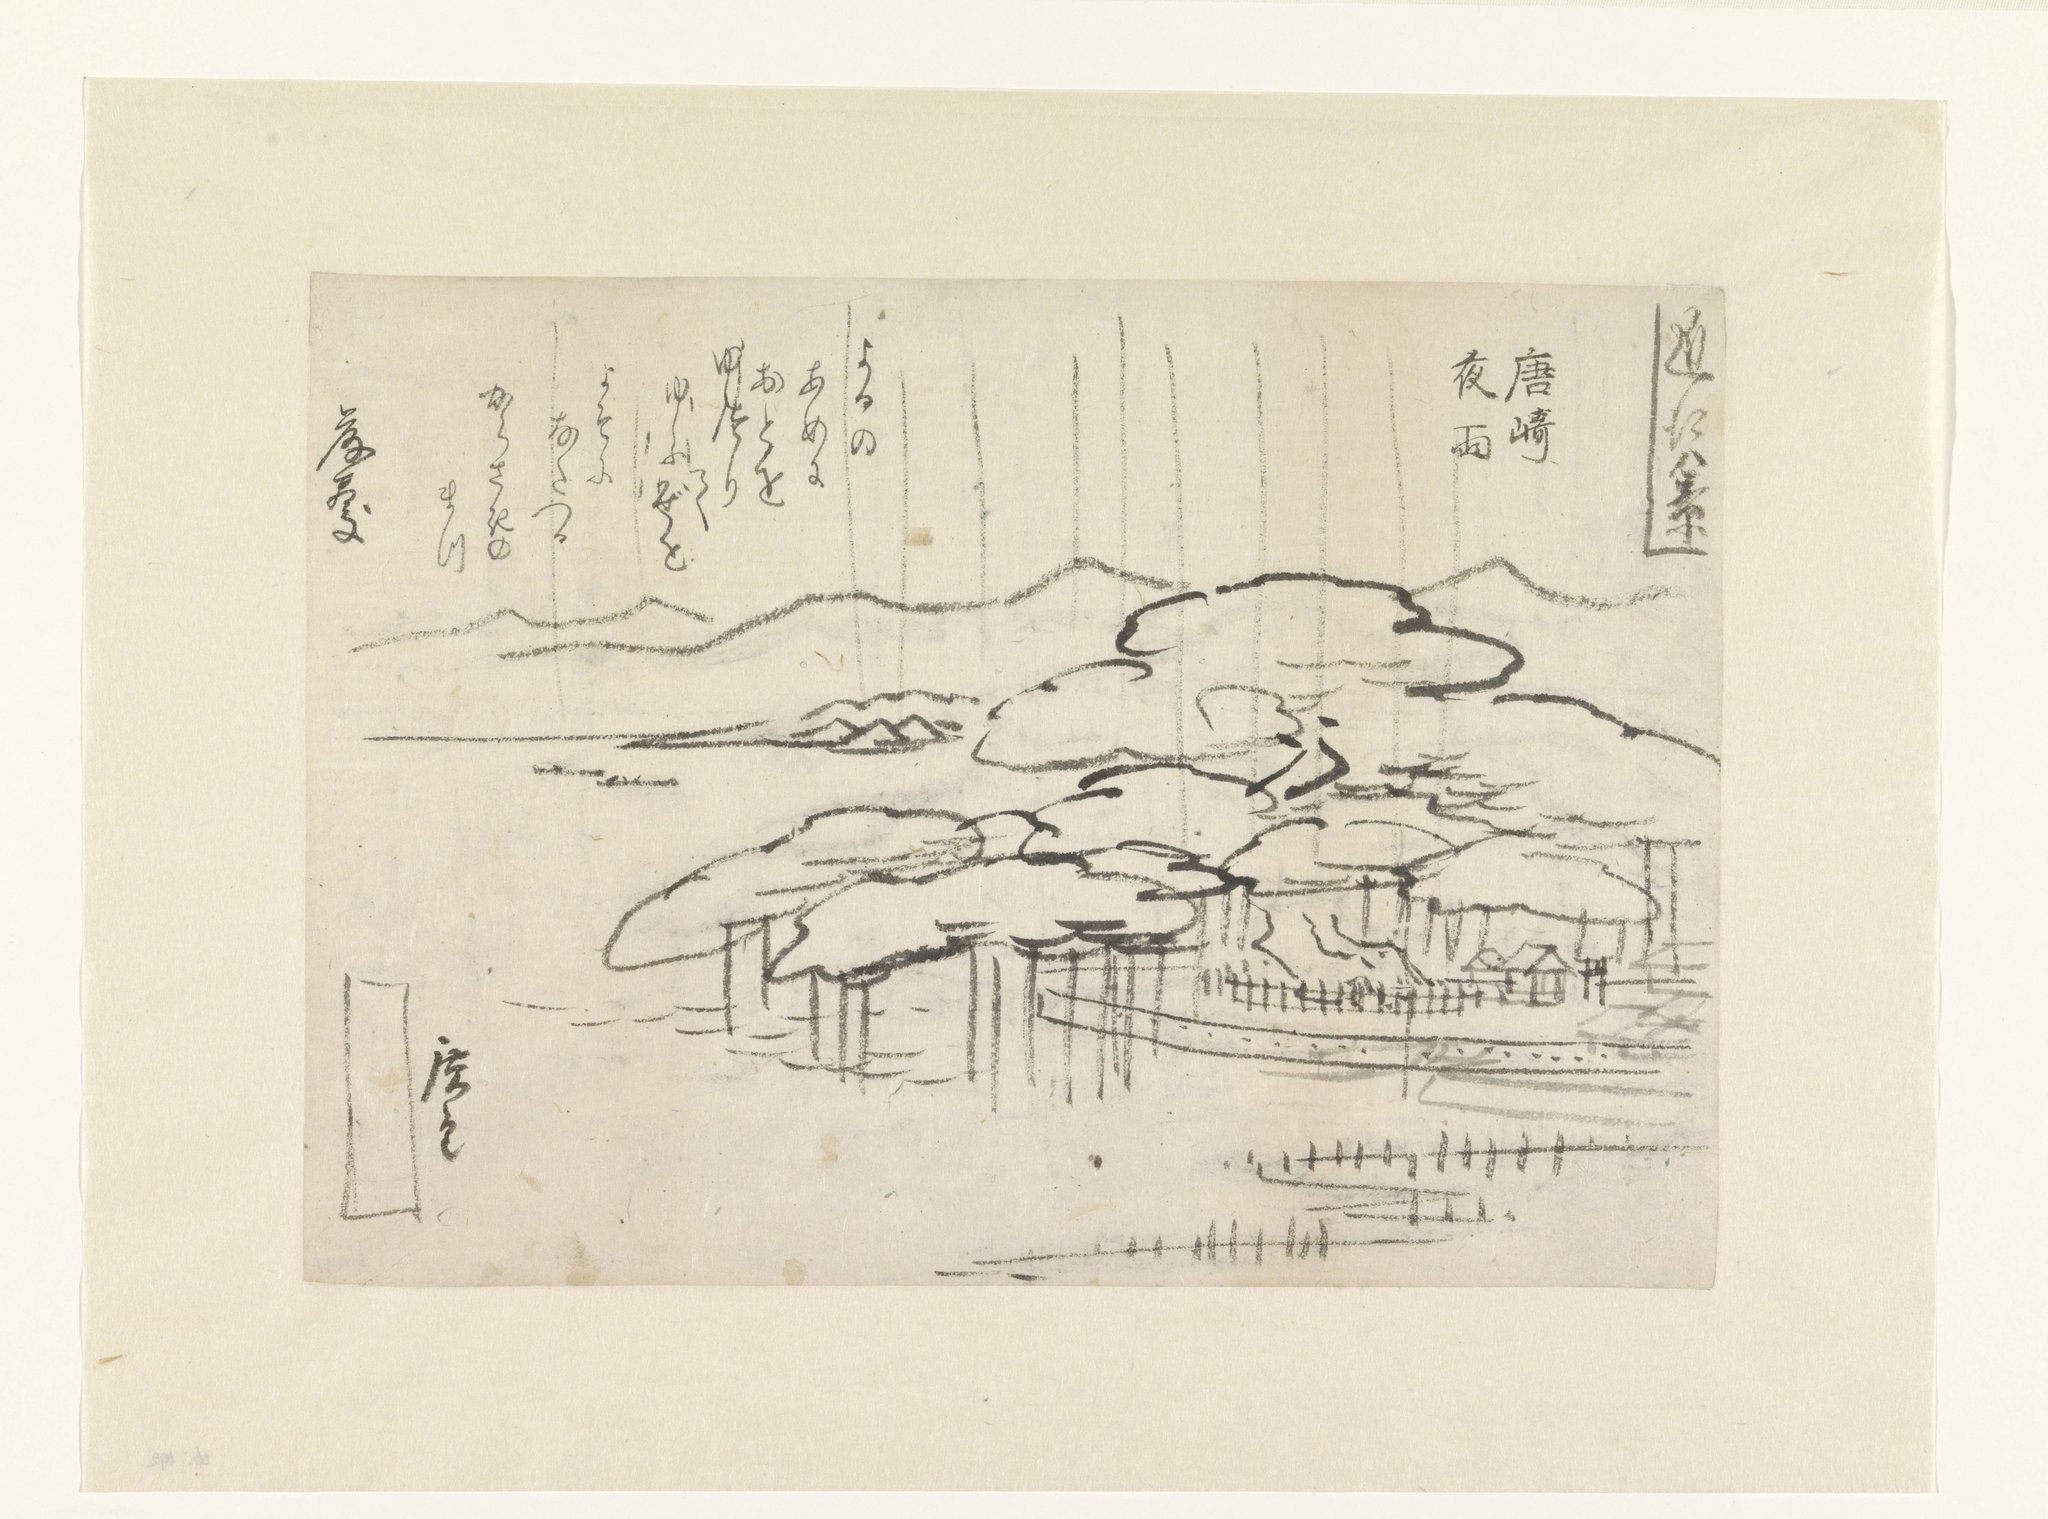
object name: drawing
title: Avondregen over Karasaki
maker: utagawa hiroshige (ii)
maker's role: print maker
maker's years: 1826-1869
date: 1836-1869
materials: paper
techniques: brush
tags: karasaki